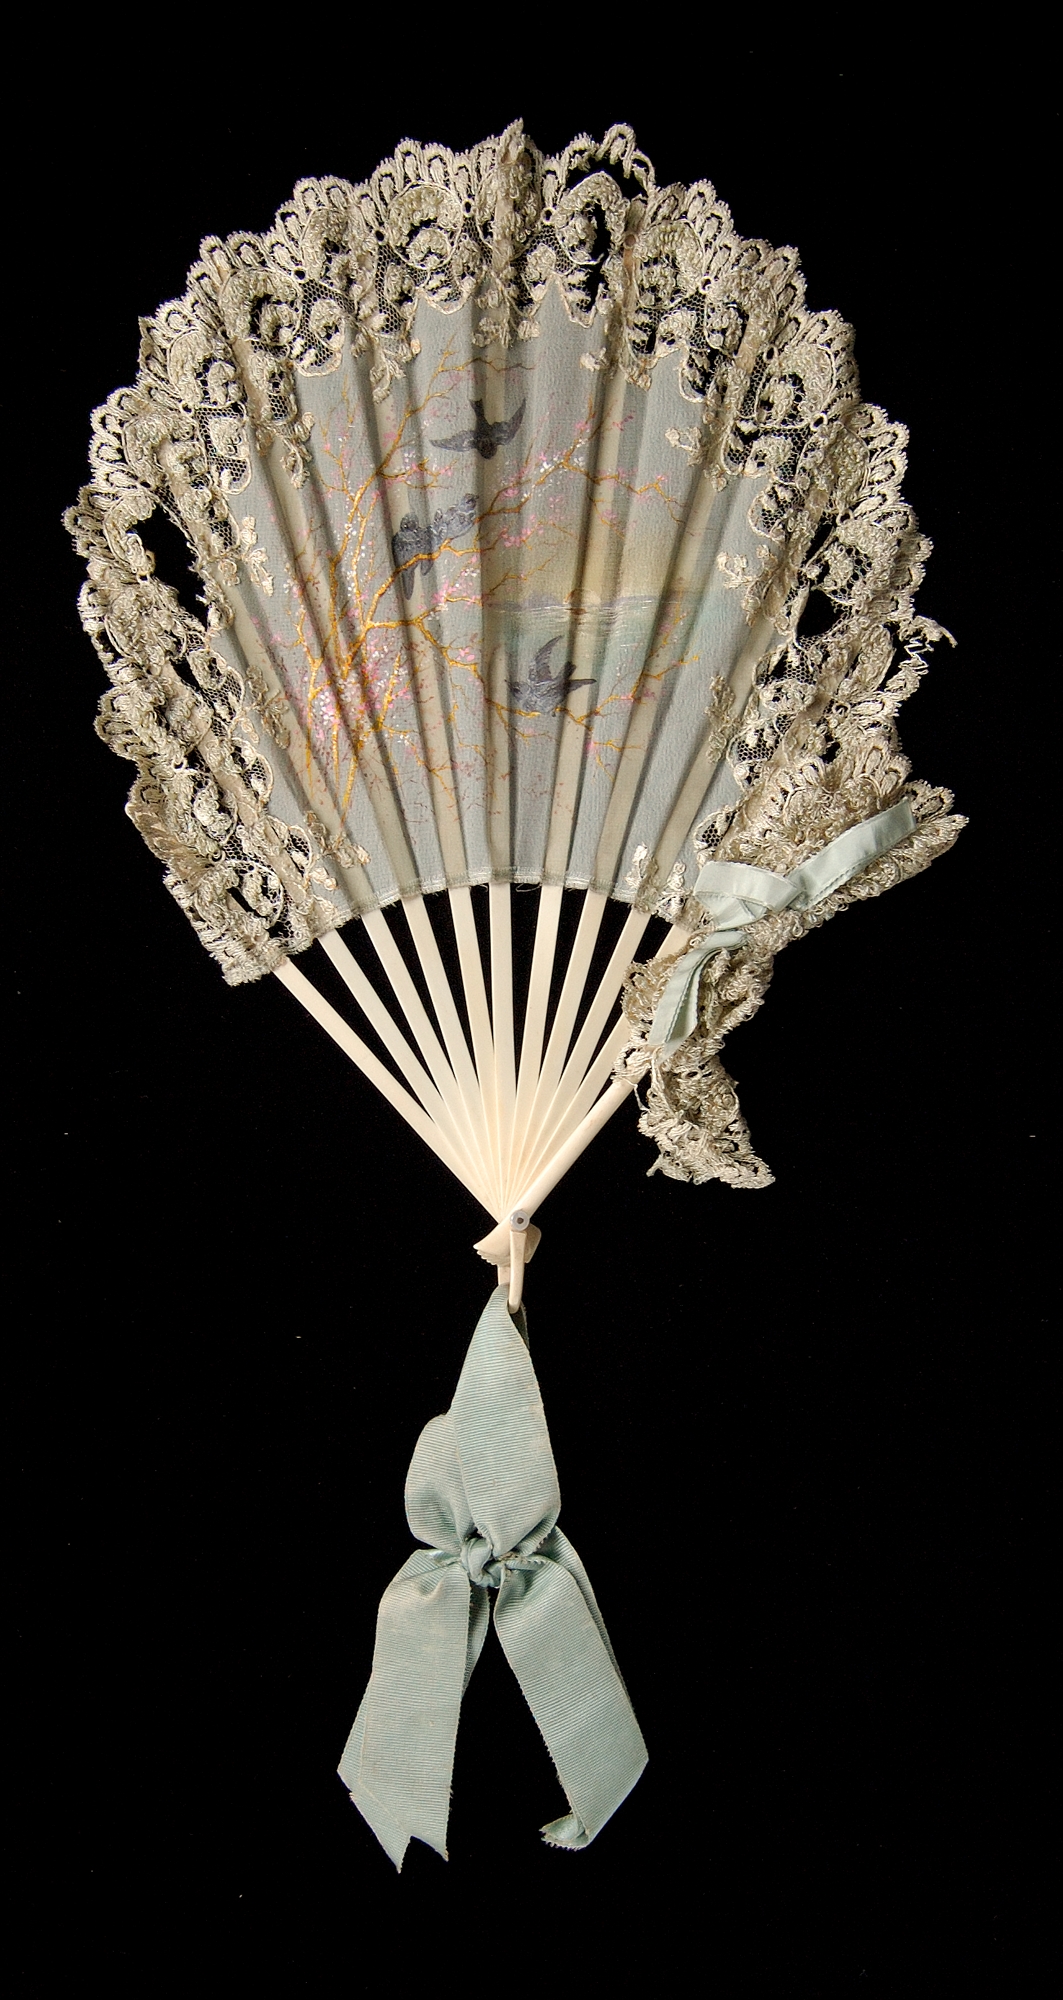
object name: fan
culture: french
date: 1880-1889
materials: ivory, mother of pearl, silk